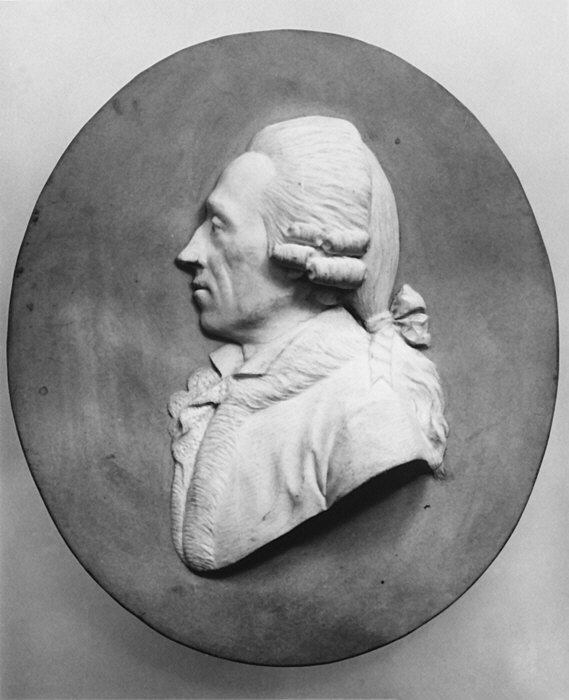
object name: medallion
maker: sèvres manufactory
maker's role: manufactory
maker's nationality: french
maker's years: 1740-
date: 1785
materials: biscuit, paste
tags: men,profiles